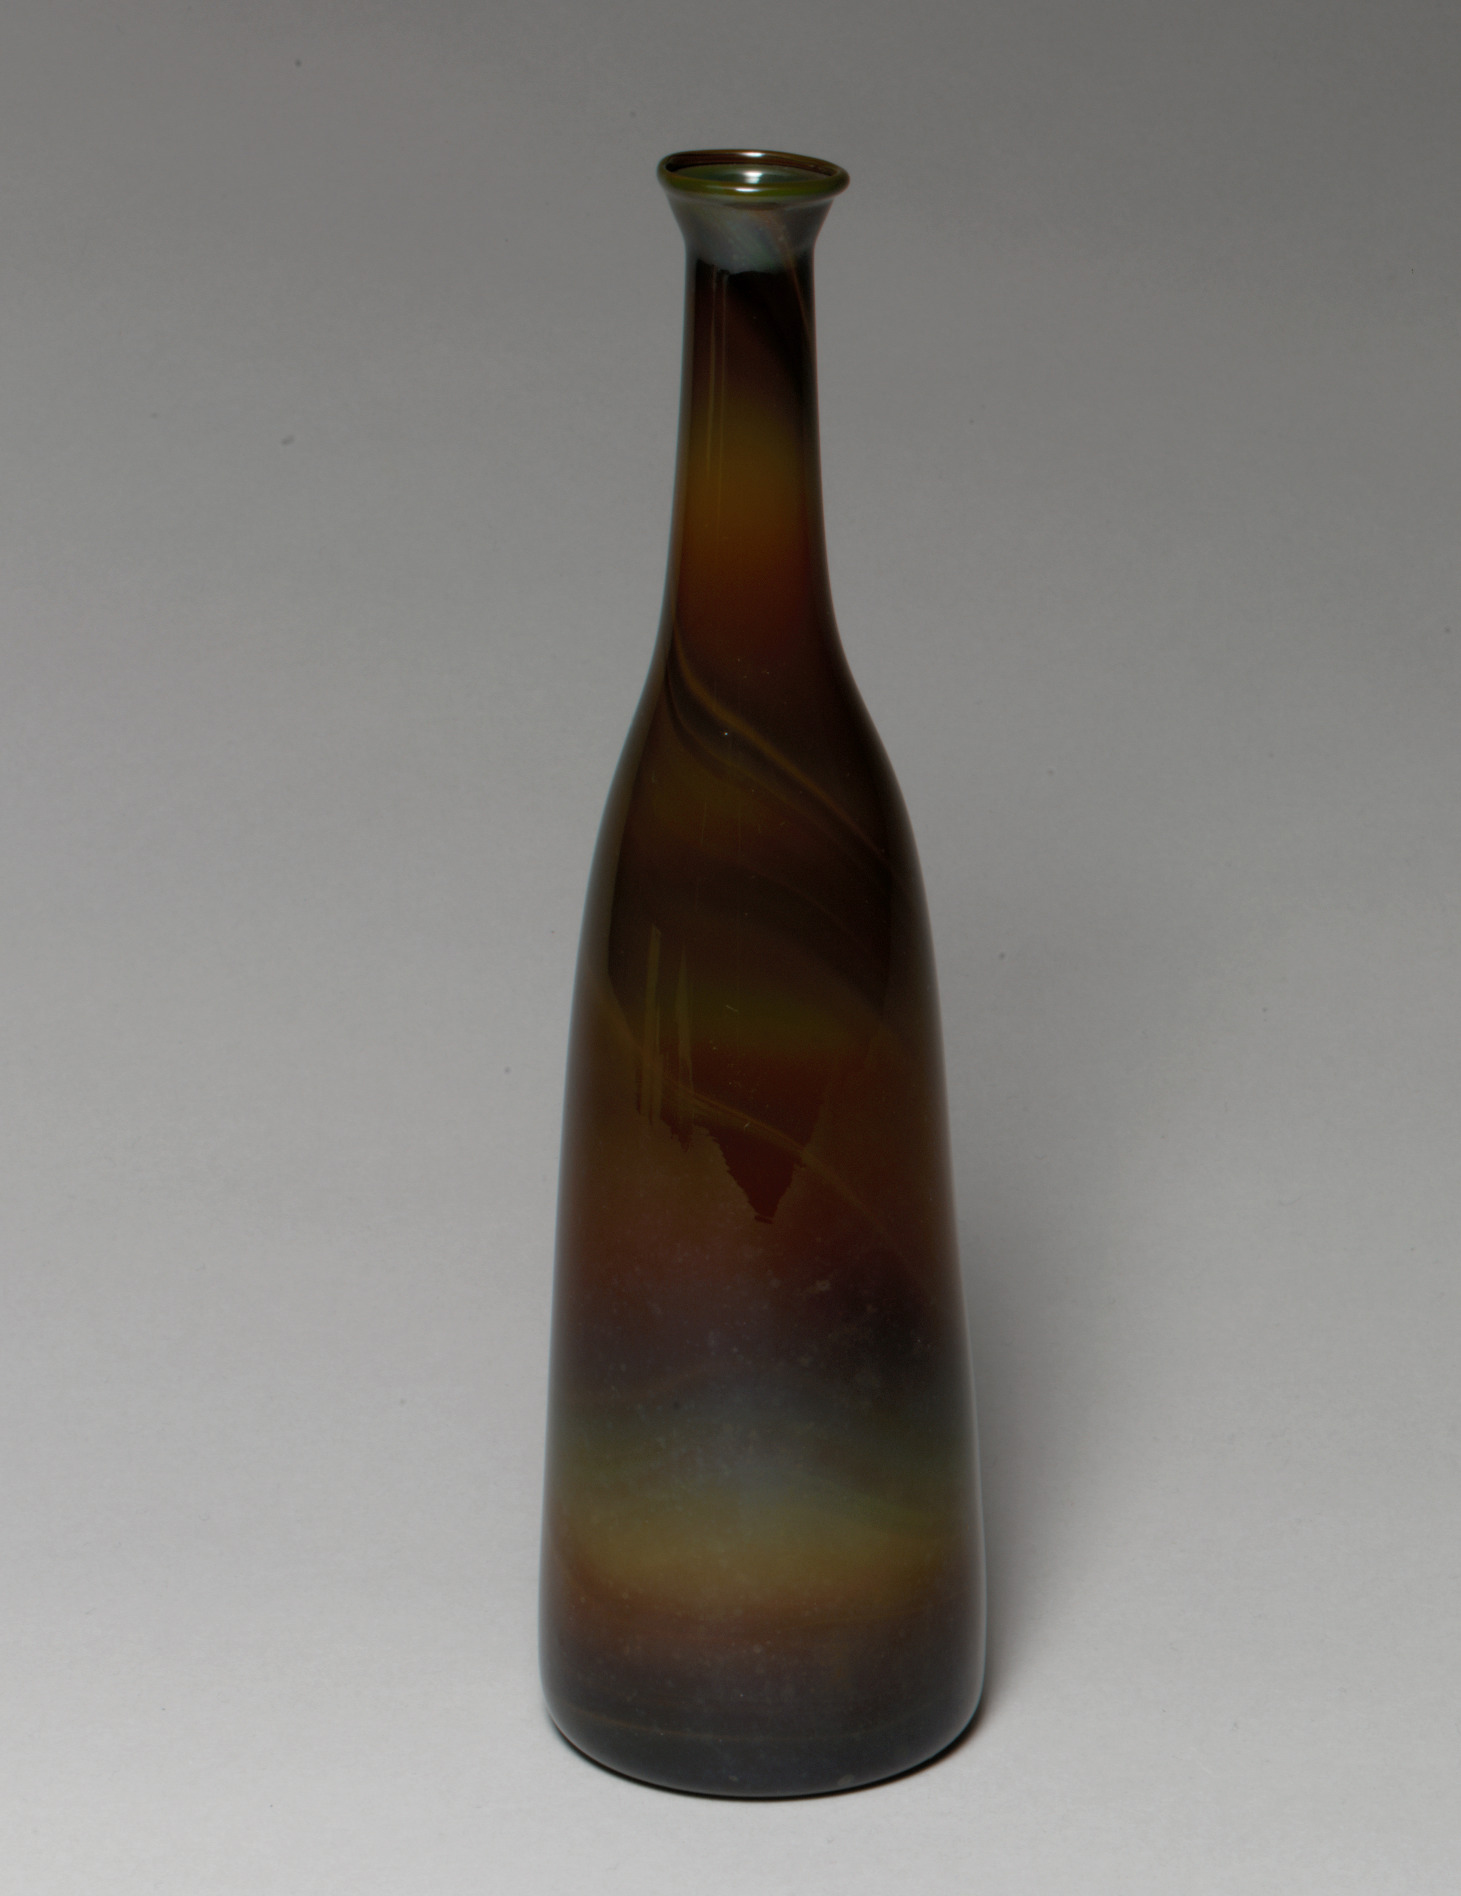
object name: wine bottle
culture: japanese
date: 1834-1866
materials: glass